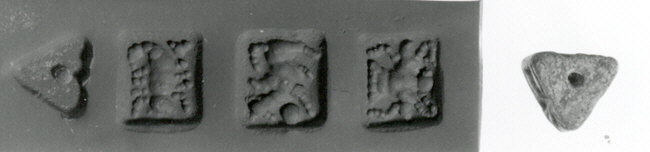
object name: stamp seal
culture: bactria-margiana archaeological complex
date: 2333-1668 BCE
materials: lapis lazuli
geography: bactria-margiana